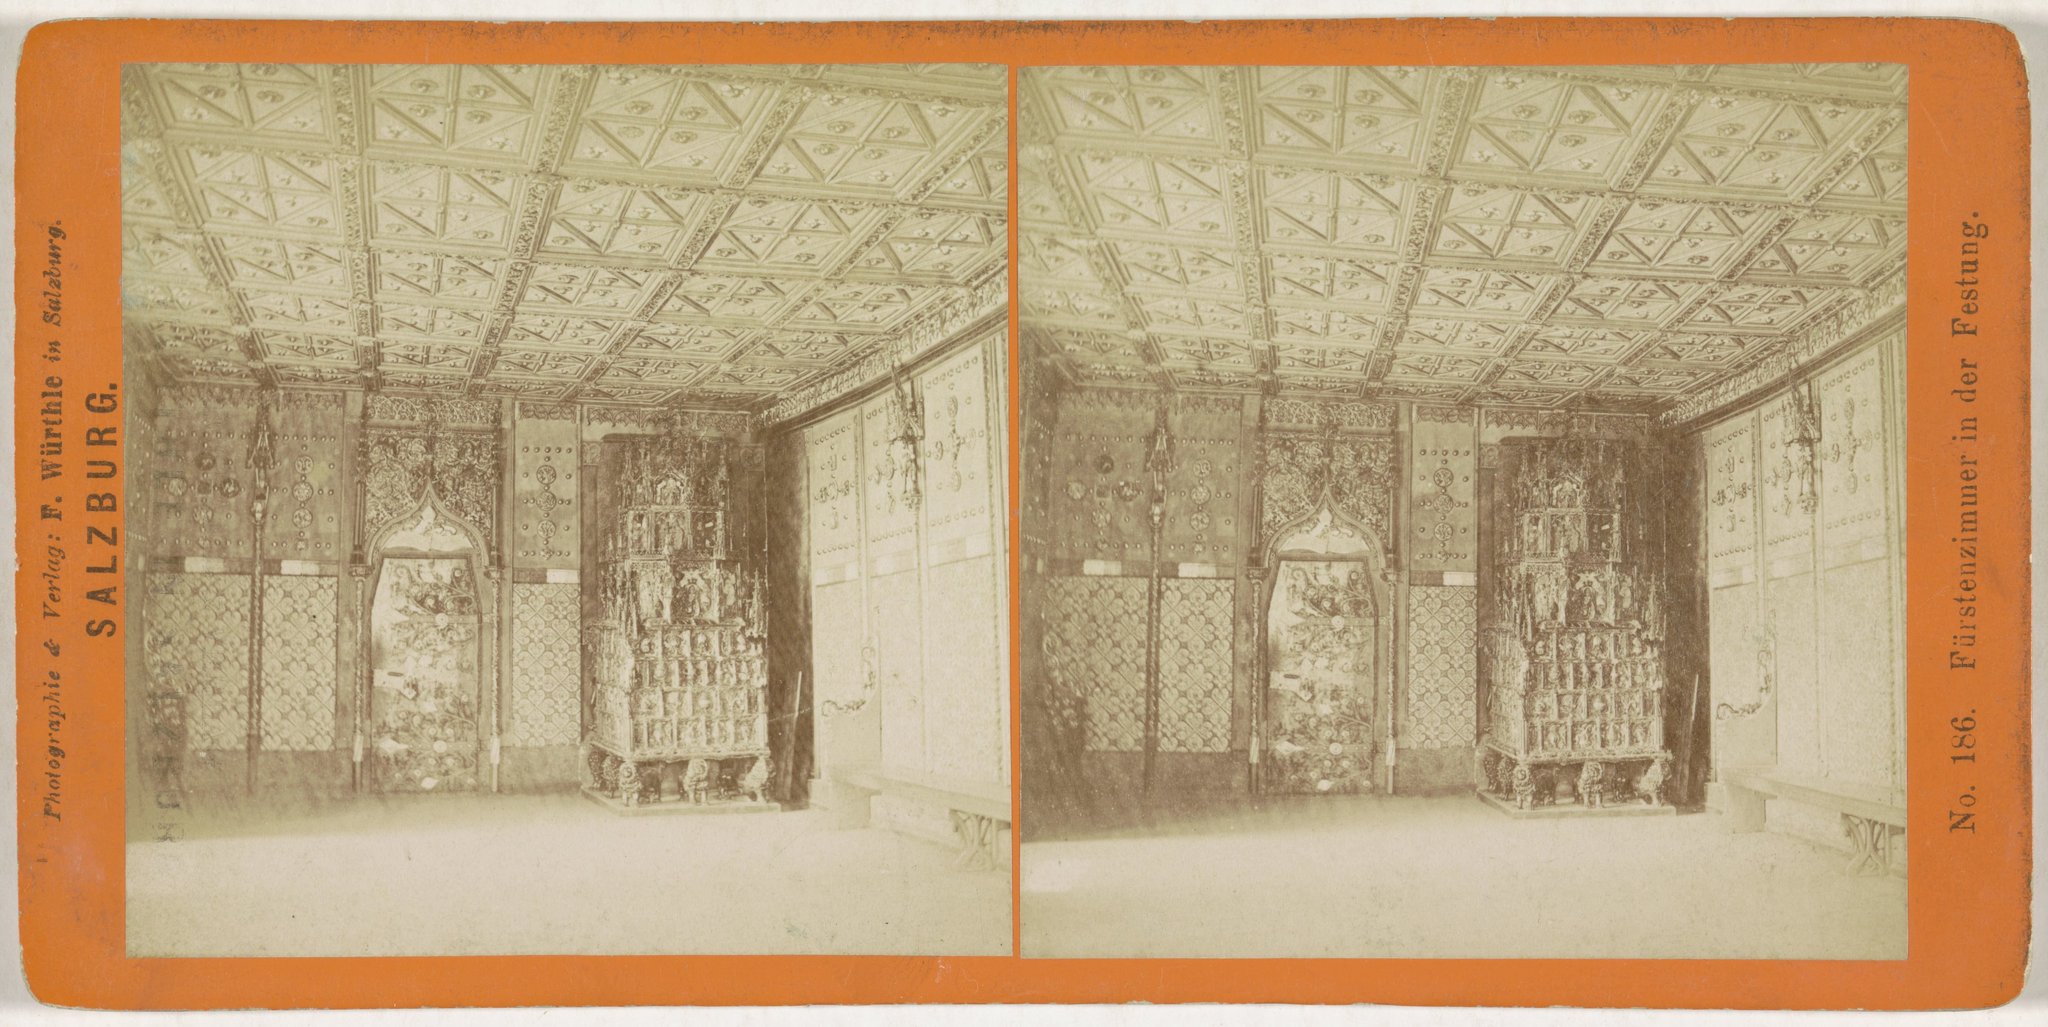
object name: stereograph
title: Fürstenzimmer in der Festung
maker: carl friedrich würthle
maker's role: print maker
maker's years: 1820-1902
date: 1874-1875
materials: cardboard, paper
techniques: albumen print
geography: salzburg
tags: palace - aa - civic architecture: inside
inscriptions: number: ‘No. 186’